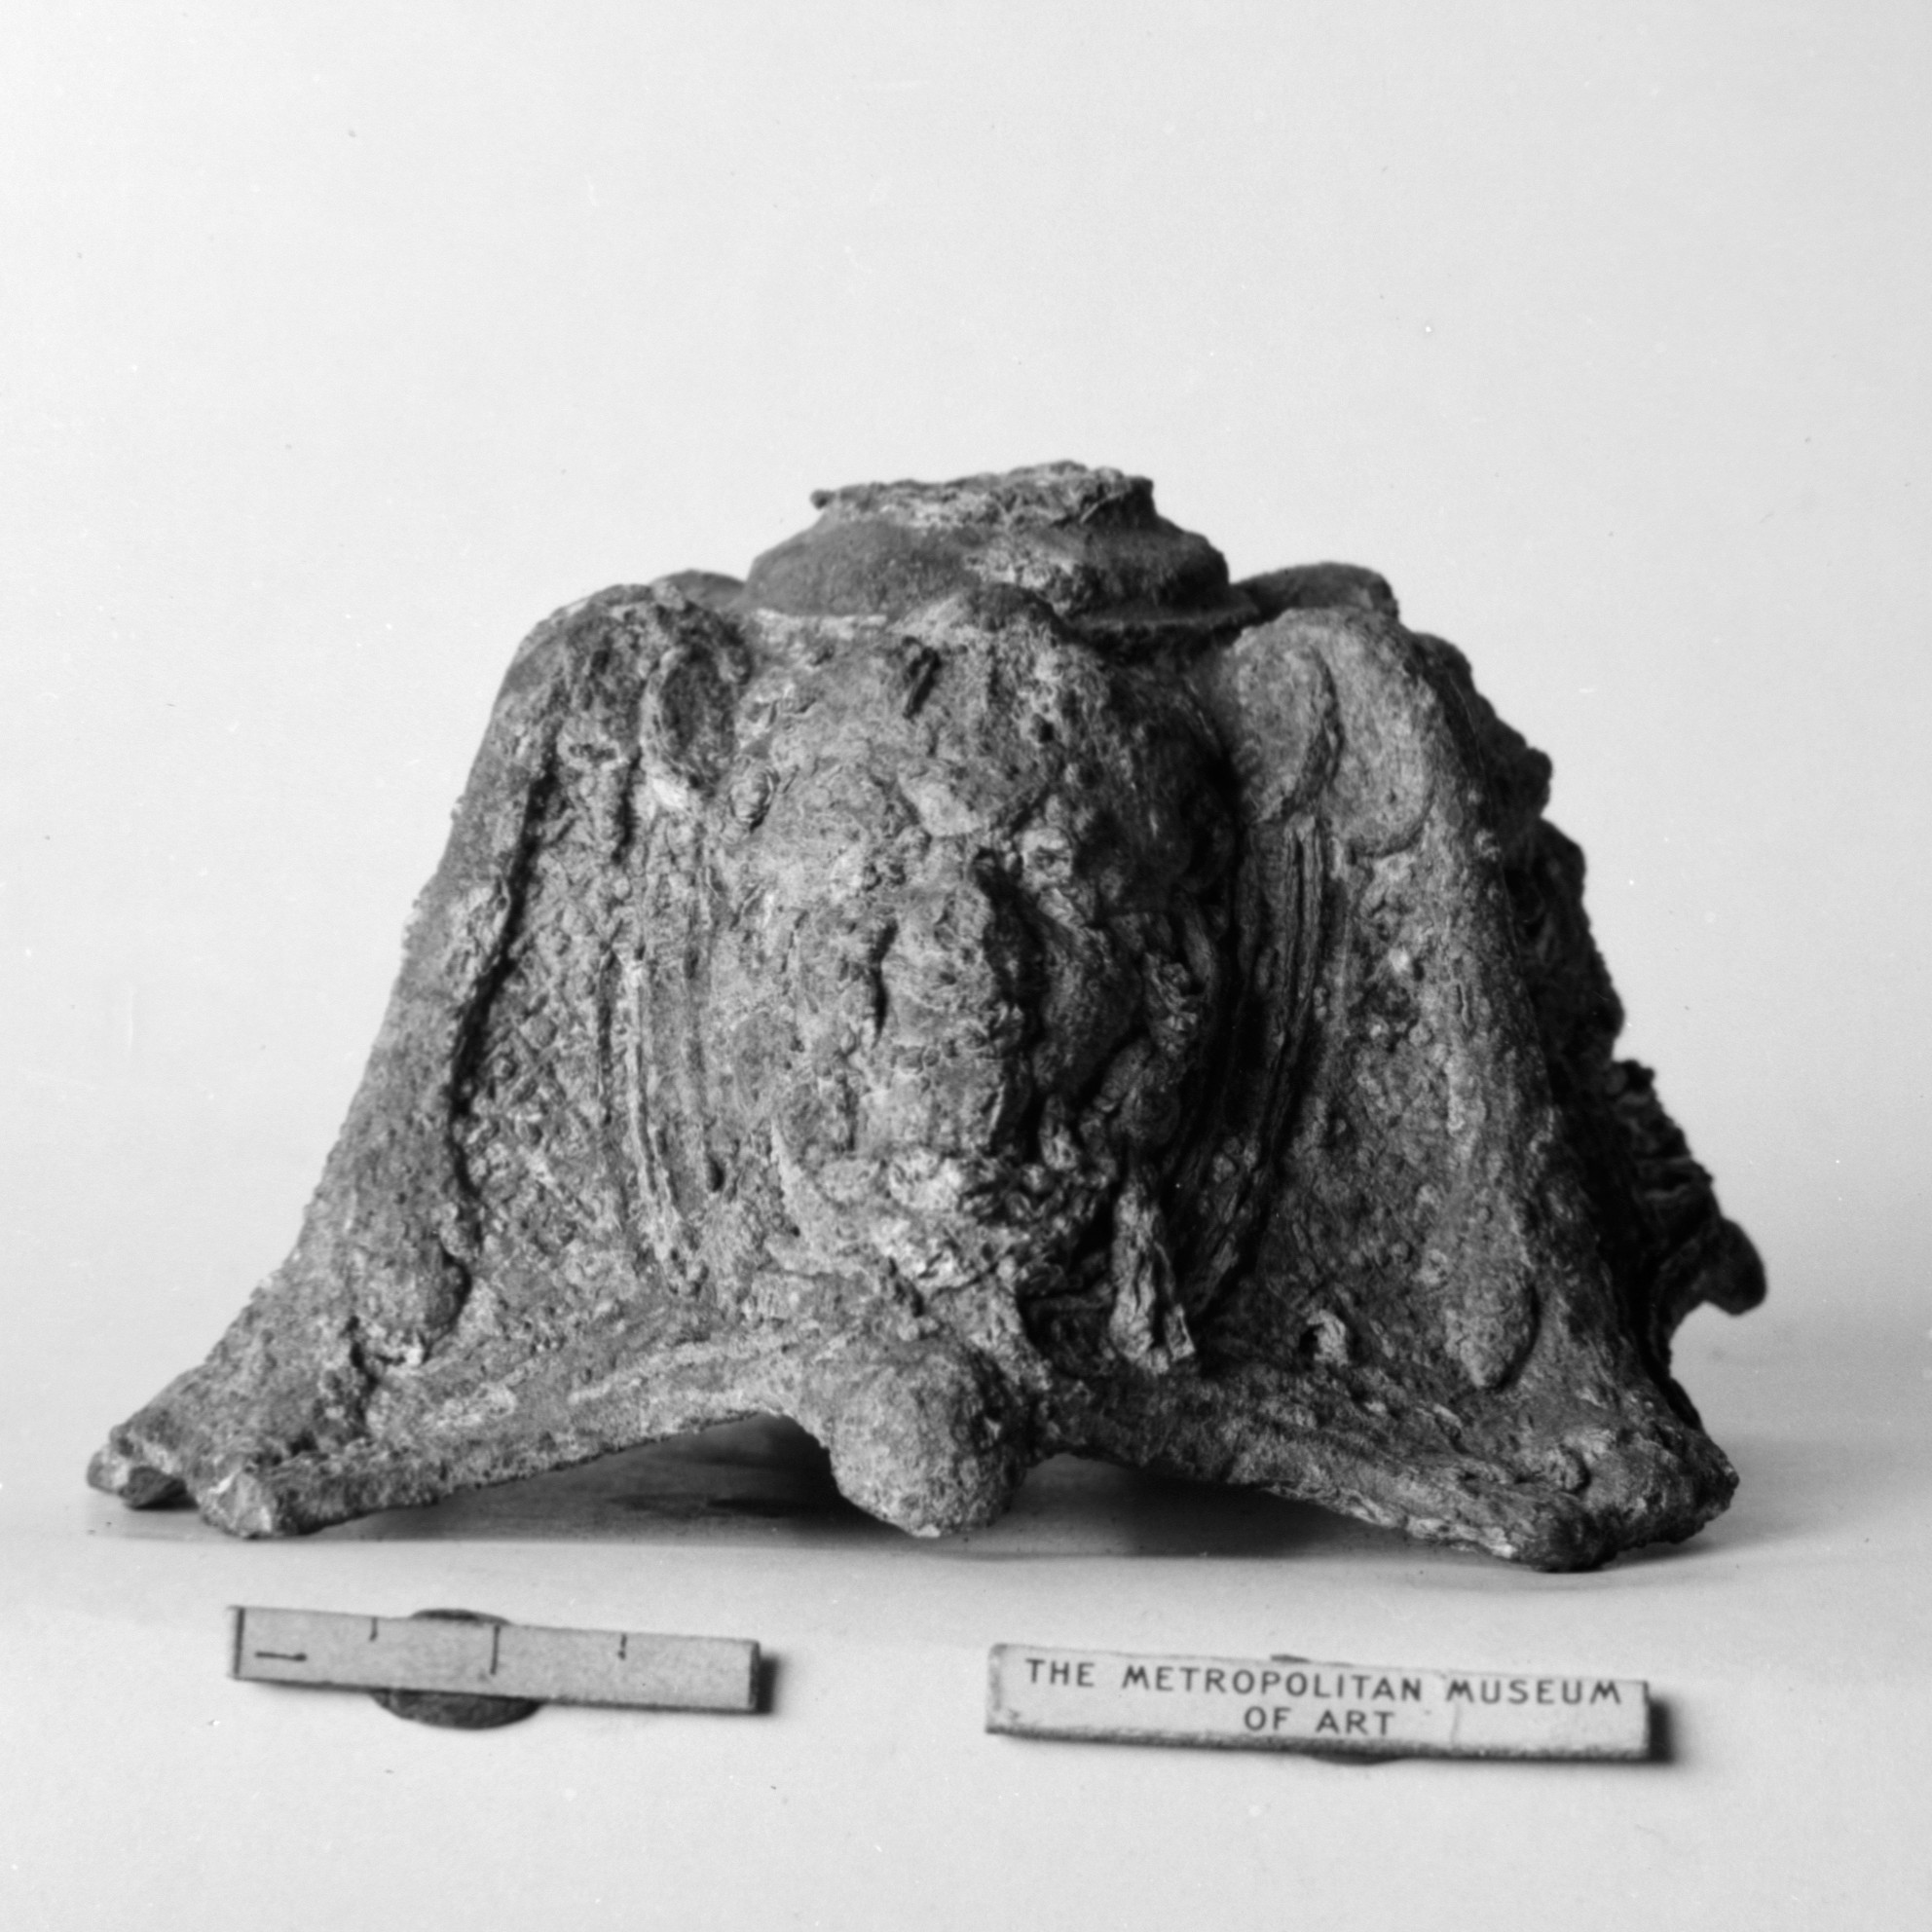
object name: base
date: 1701-1900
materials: lead